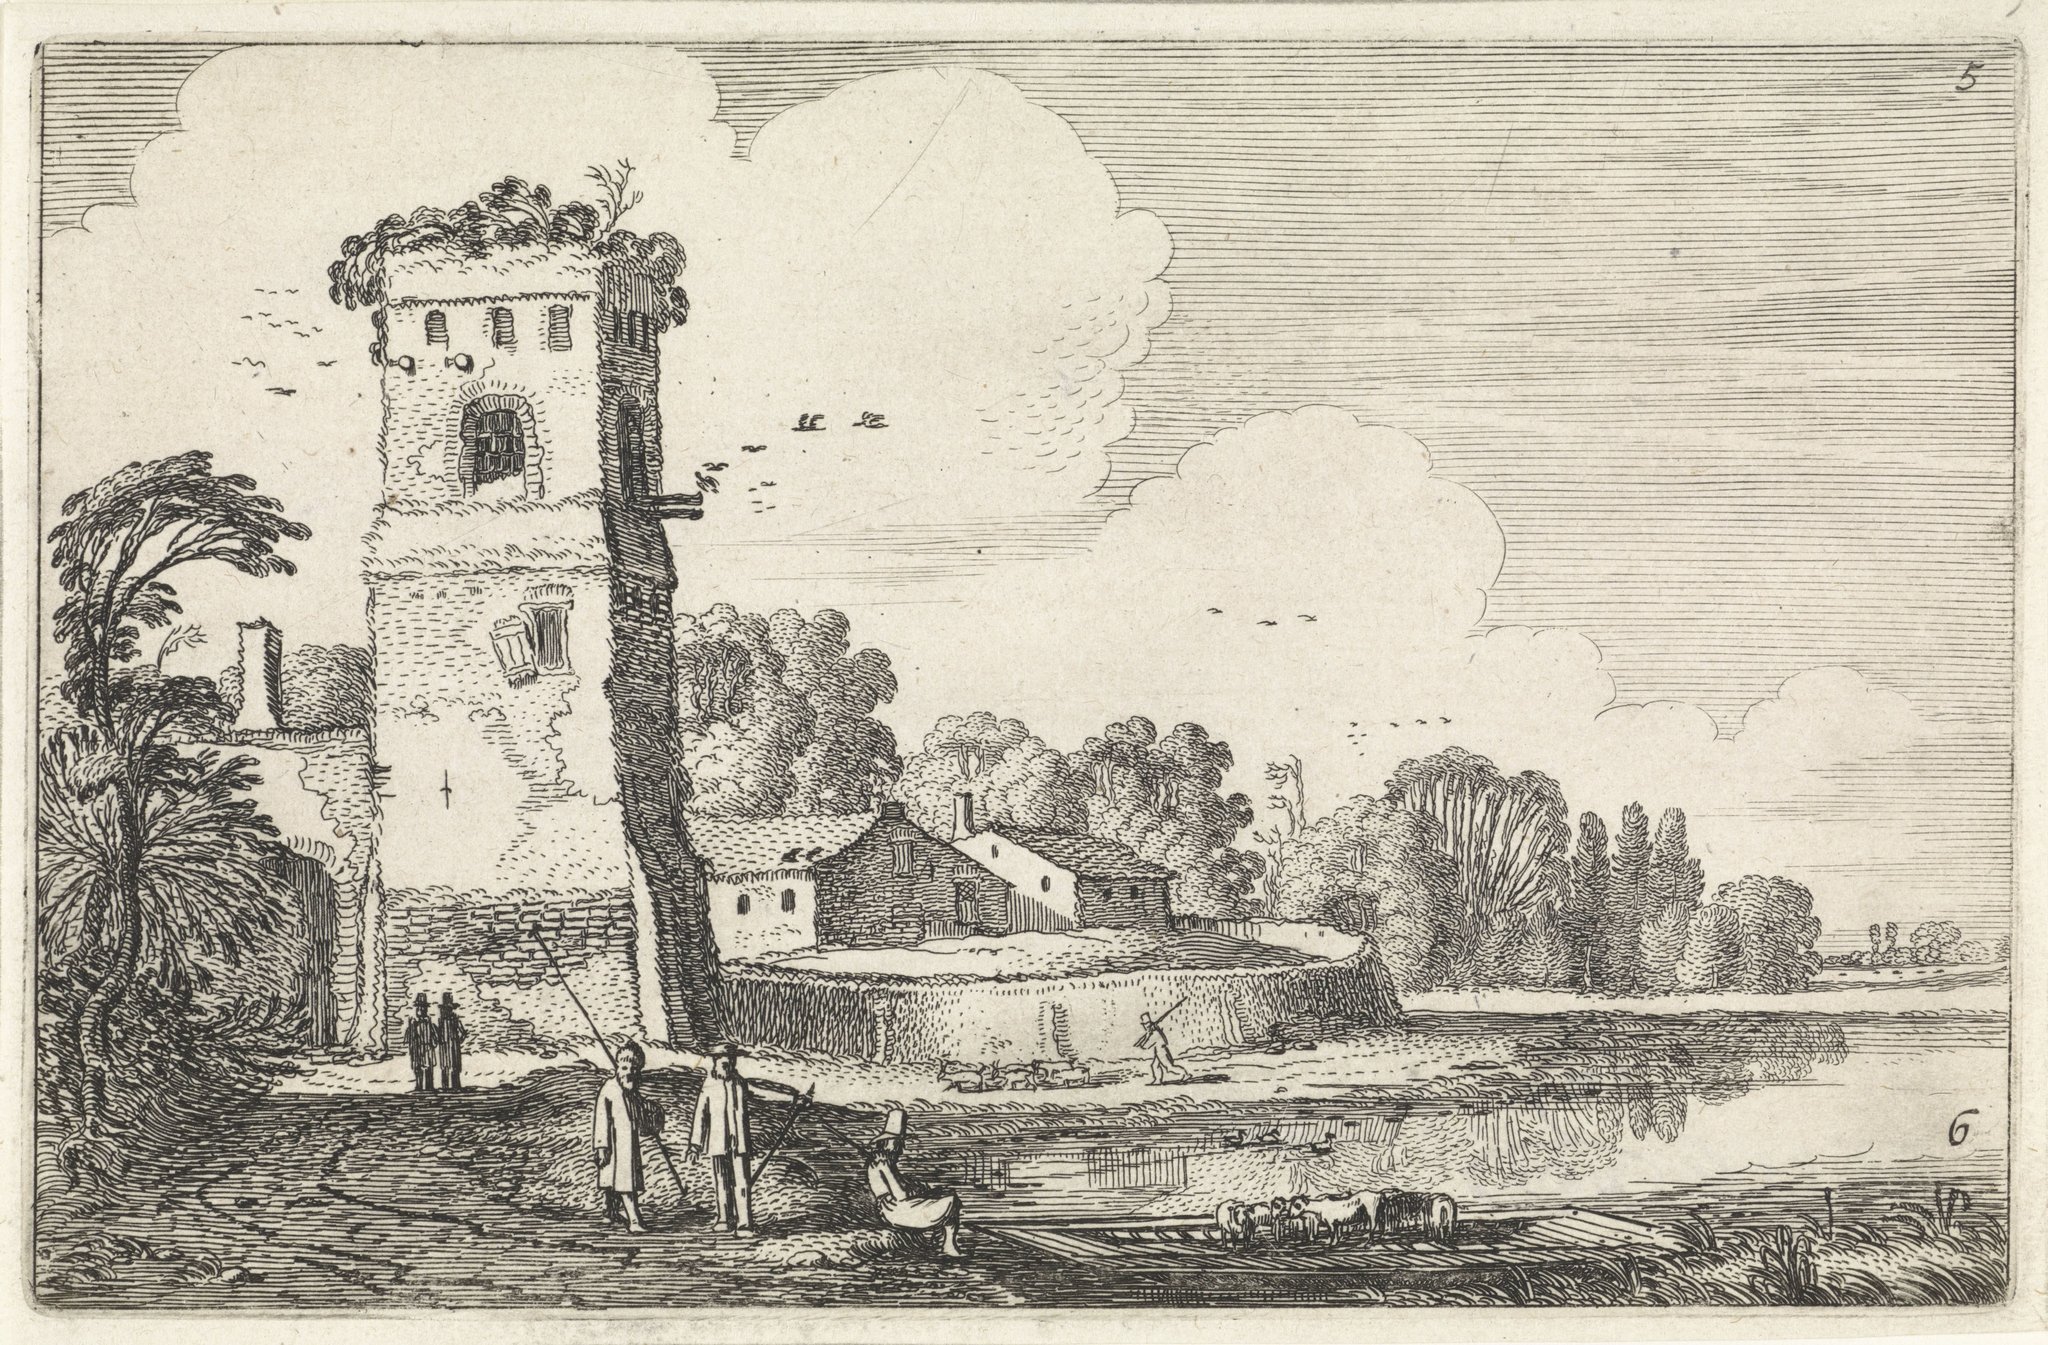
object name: print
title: Amenissimae aliquot requculae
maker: jan van de velde (ii)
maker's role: draughtsman, painter, print maker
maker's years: 1593-1641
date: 1616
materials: paper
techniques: etching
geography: northern netherlands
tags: river, landscape with tower or castle, ferry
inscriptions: collector's mark: Lugt 964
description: Een pont met daarop schapen bij een vierkante toren in rivierlandschap. Daarbij twee huizen met een muur eromheen. Zesde prent van deel vijf van een serie van in totaal zestig prenten met landschappen, verdeeld over vijf delen van elk twaalf prenten.